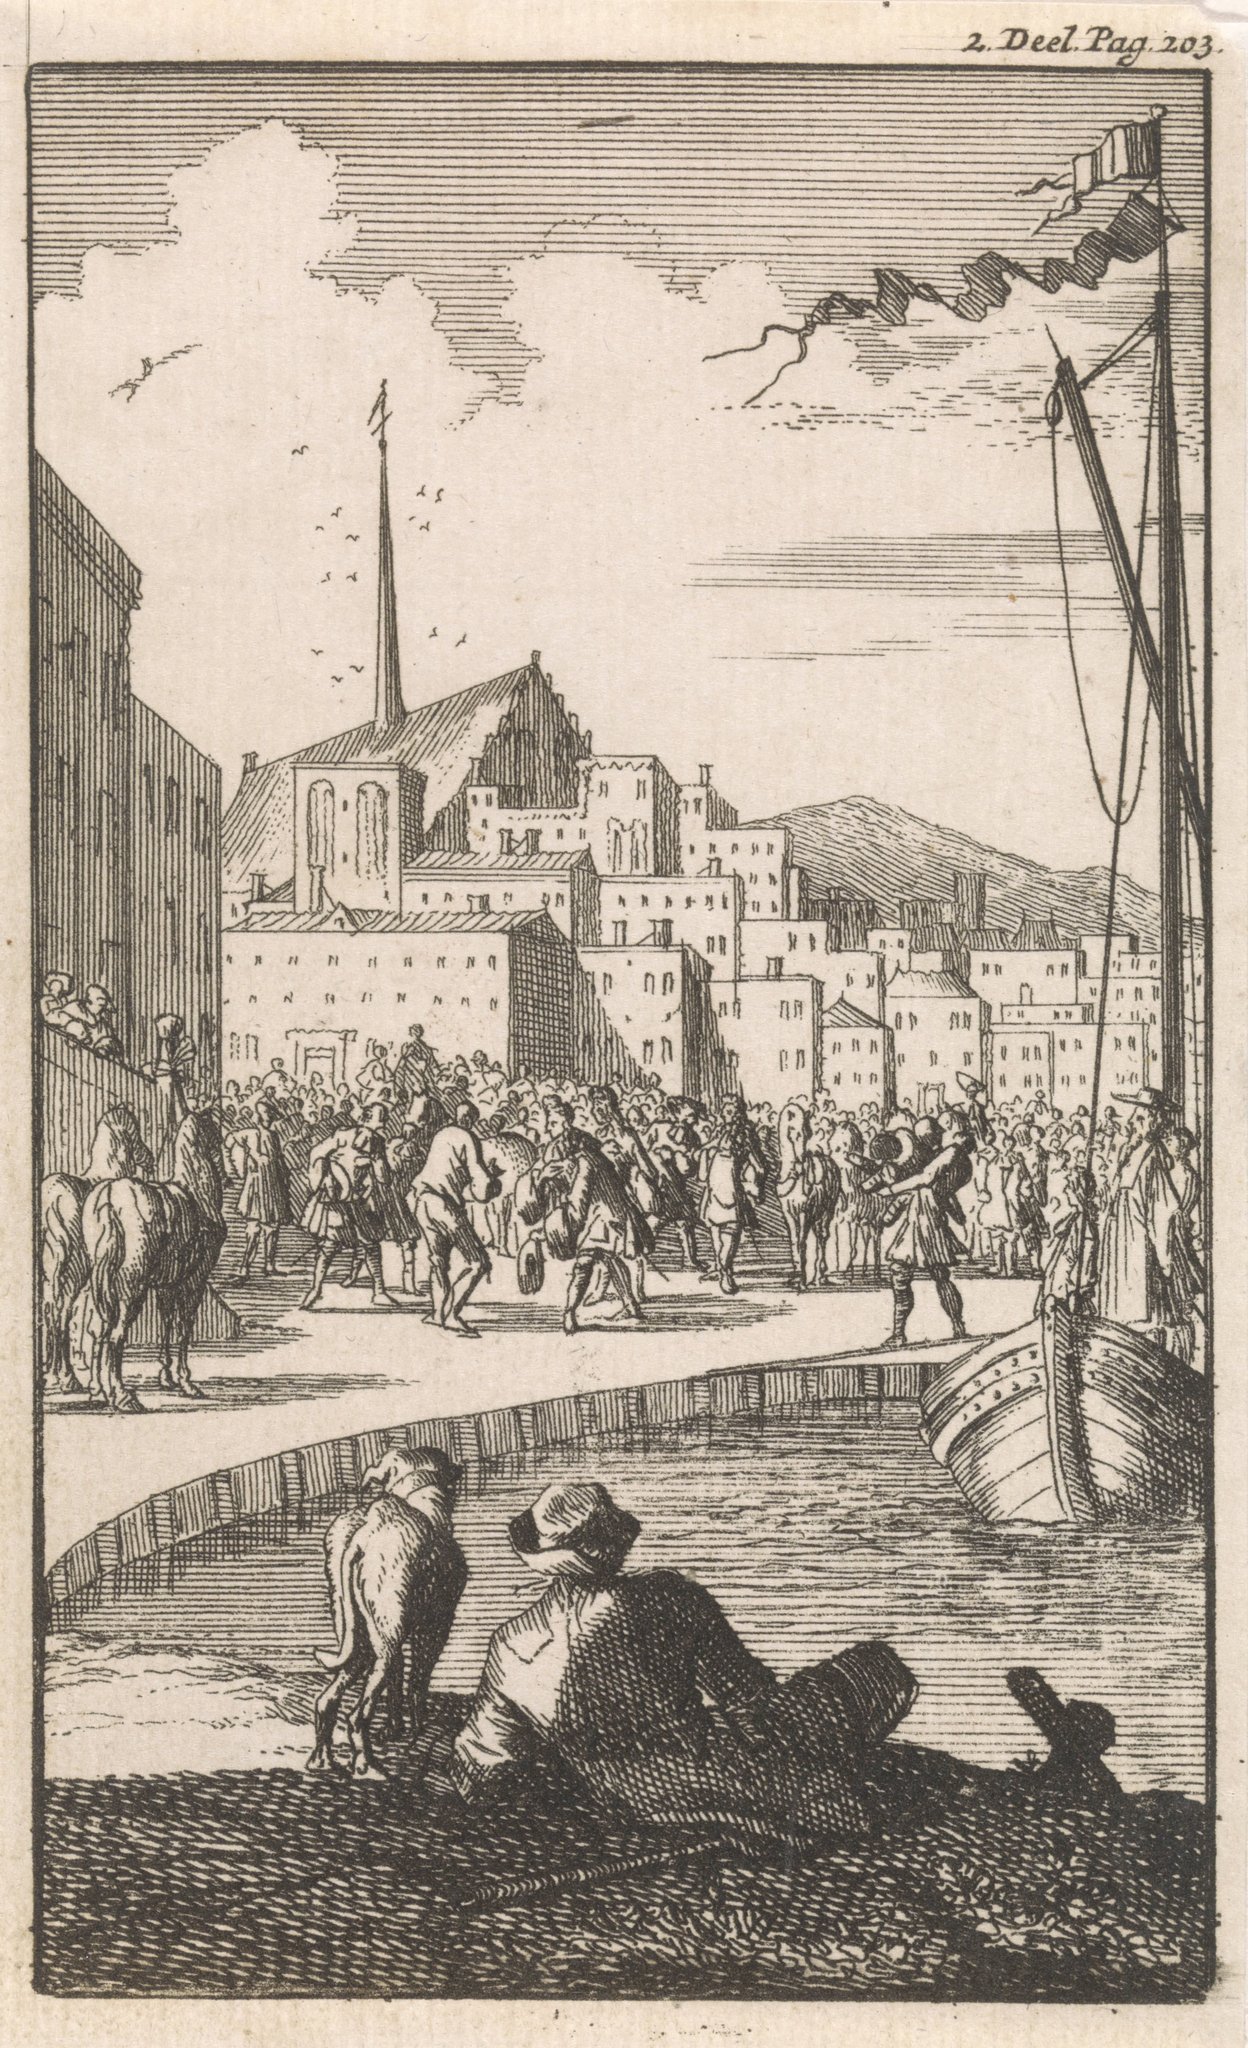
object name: book illustration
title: Don Clarazel wordt bij het verlaten van het schip van Mussabelin ontvangen door de hertog van Nevers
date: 1697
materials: paper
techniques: etching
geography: amsterdam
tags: being welcomed ~ travelling, pier, quay, wharf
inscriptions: collector's mark: Lugt 2228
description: Illustratie uit: Verdier, Gilbert Saulnier du (vert. Heinsius, Nicolaas junior). Don Clarazel de Gontarnos, ofte den buiten-spoorigen dolenden ridder, 2 delen. Amsterdam: Johannes Broersz en Nathanael Holbeex, 1697, dl. 2.